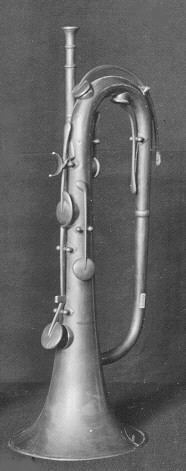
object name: keyed bugle in b flat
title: Keyed Bugle in B-flat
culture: belgian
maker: c. devaster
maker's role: maker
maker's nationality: belgian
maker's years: 1800-1850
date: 1830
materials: brass, copper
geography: belgium